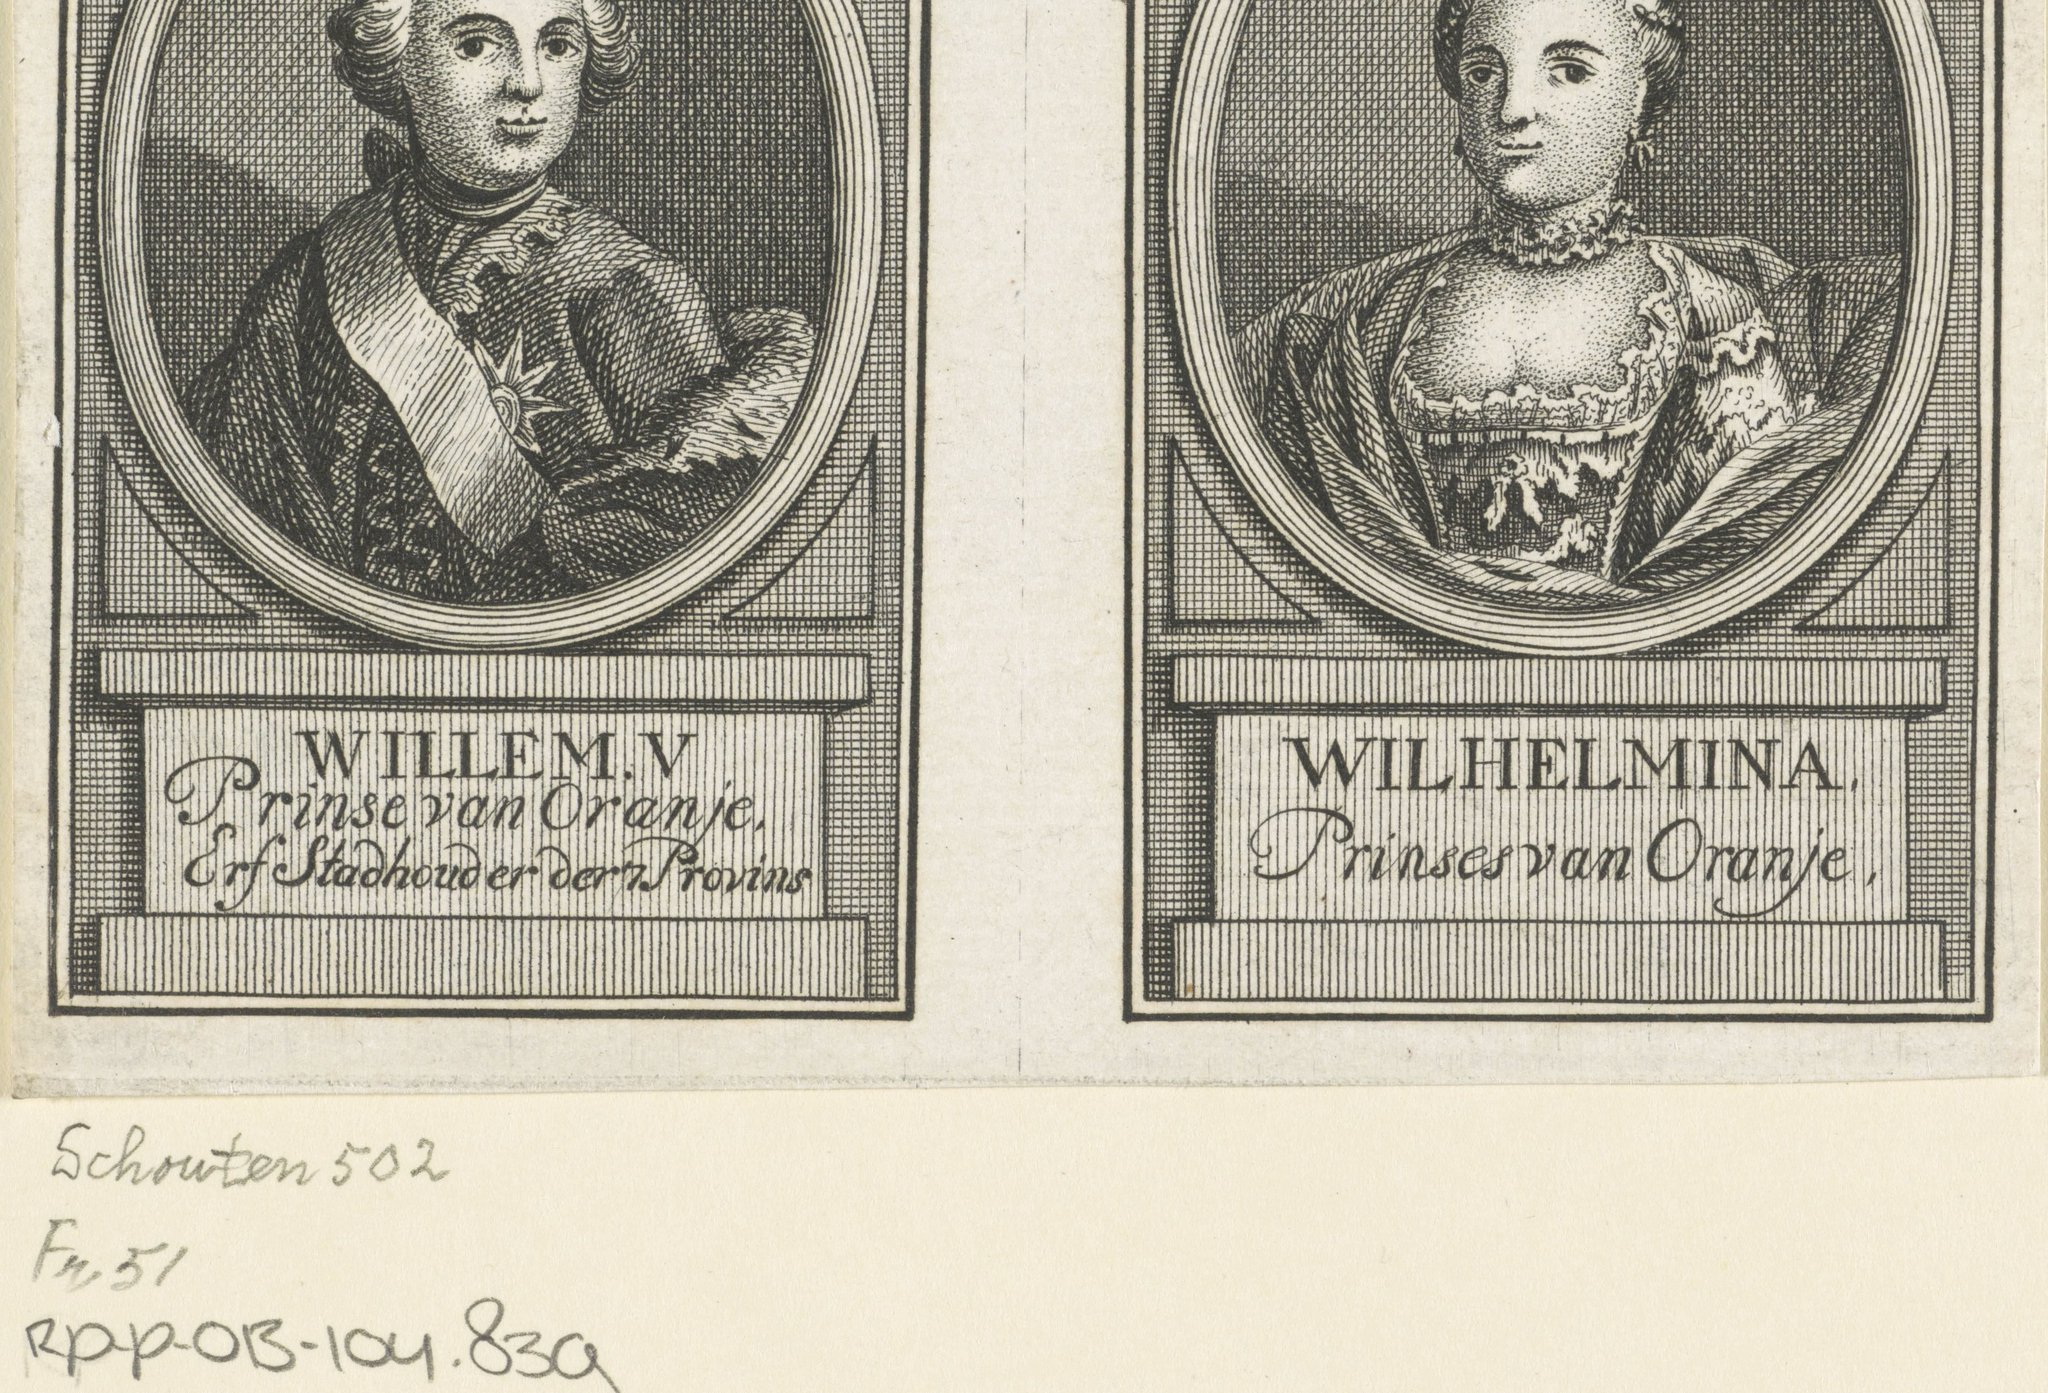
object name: print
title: Portretten van Willem V, prins van Oranje-Nassau, en Wilhelmina van Pruisen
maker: Anonymous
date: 1767-1849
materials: paper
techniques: engraving, etching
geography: low countries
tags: william v (prince of orange), berlin, painter, wilhelmina of prussia (princess of orange)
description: De hier vermelde titel verwijst naar de hoogst verkregen titel van de geportretteerde, niet per se naar de titel die de geportretteerde op deze voorstelling draagt.